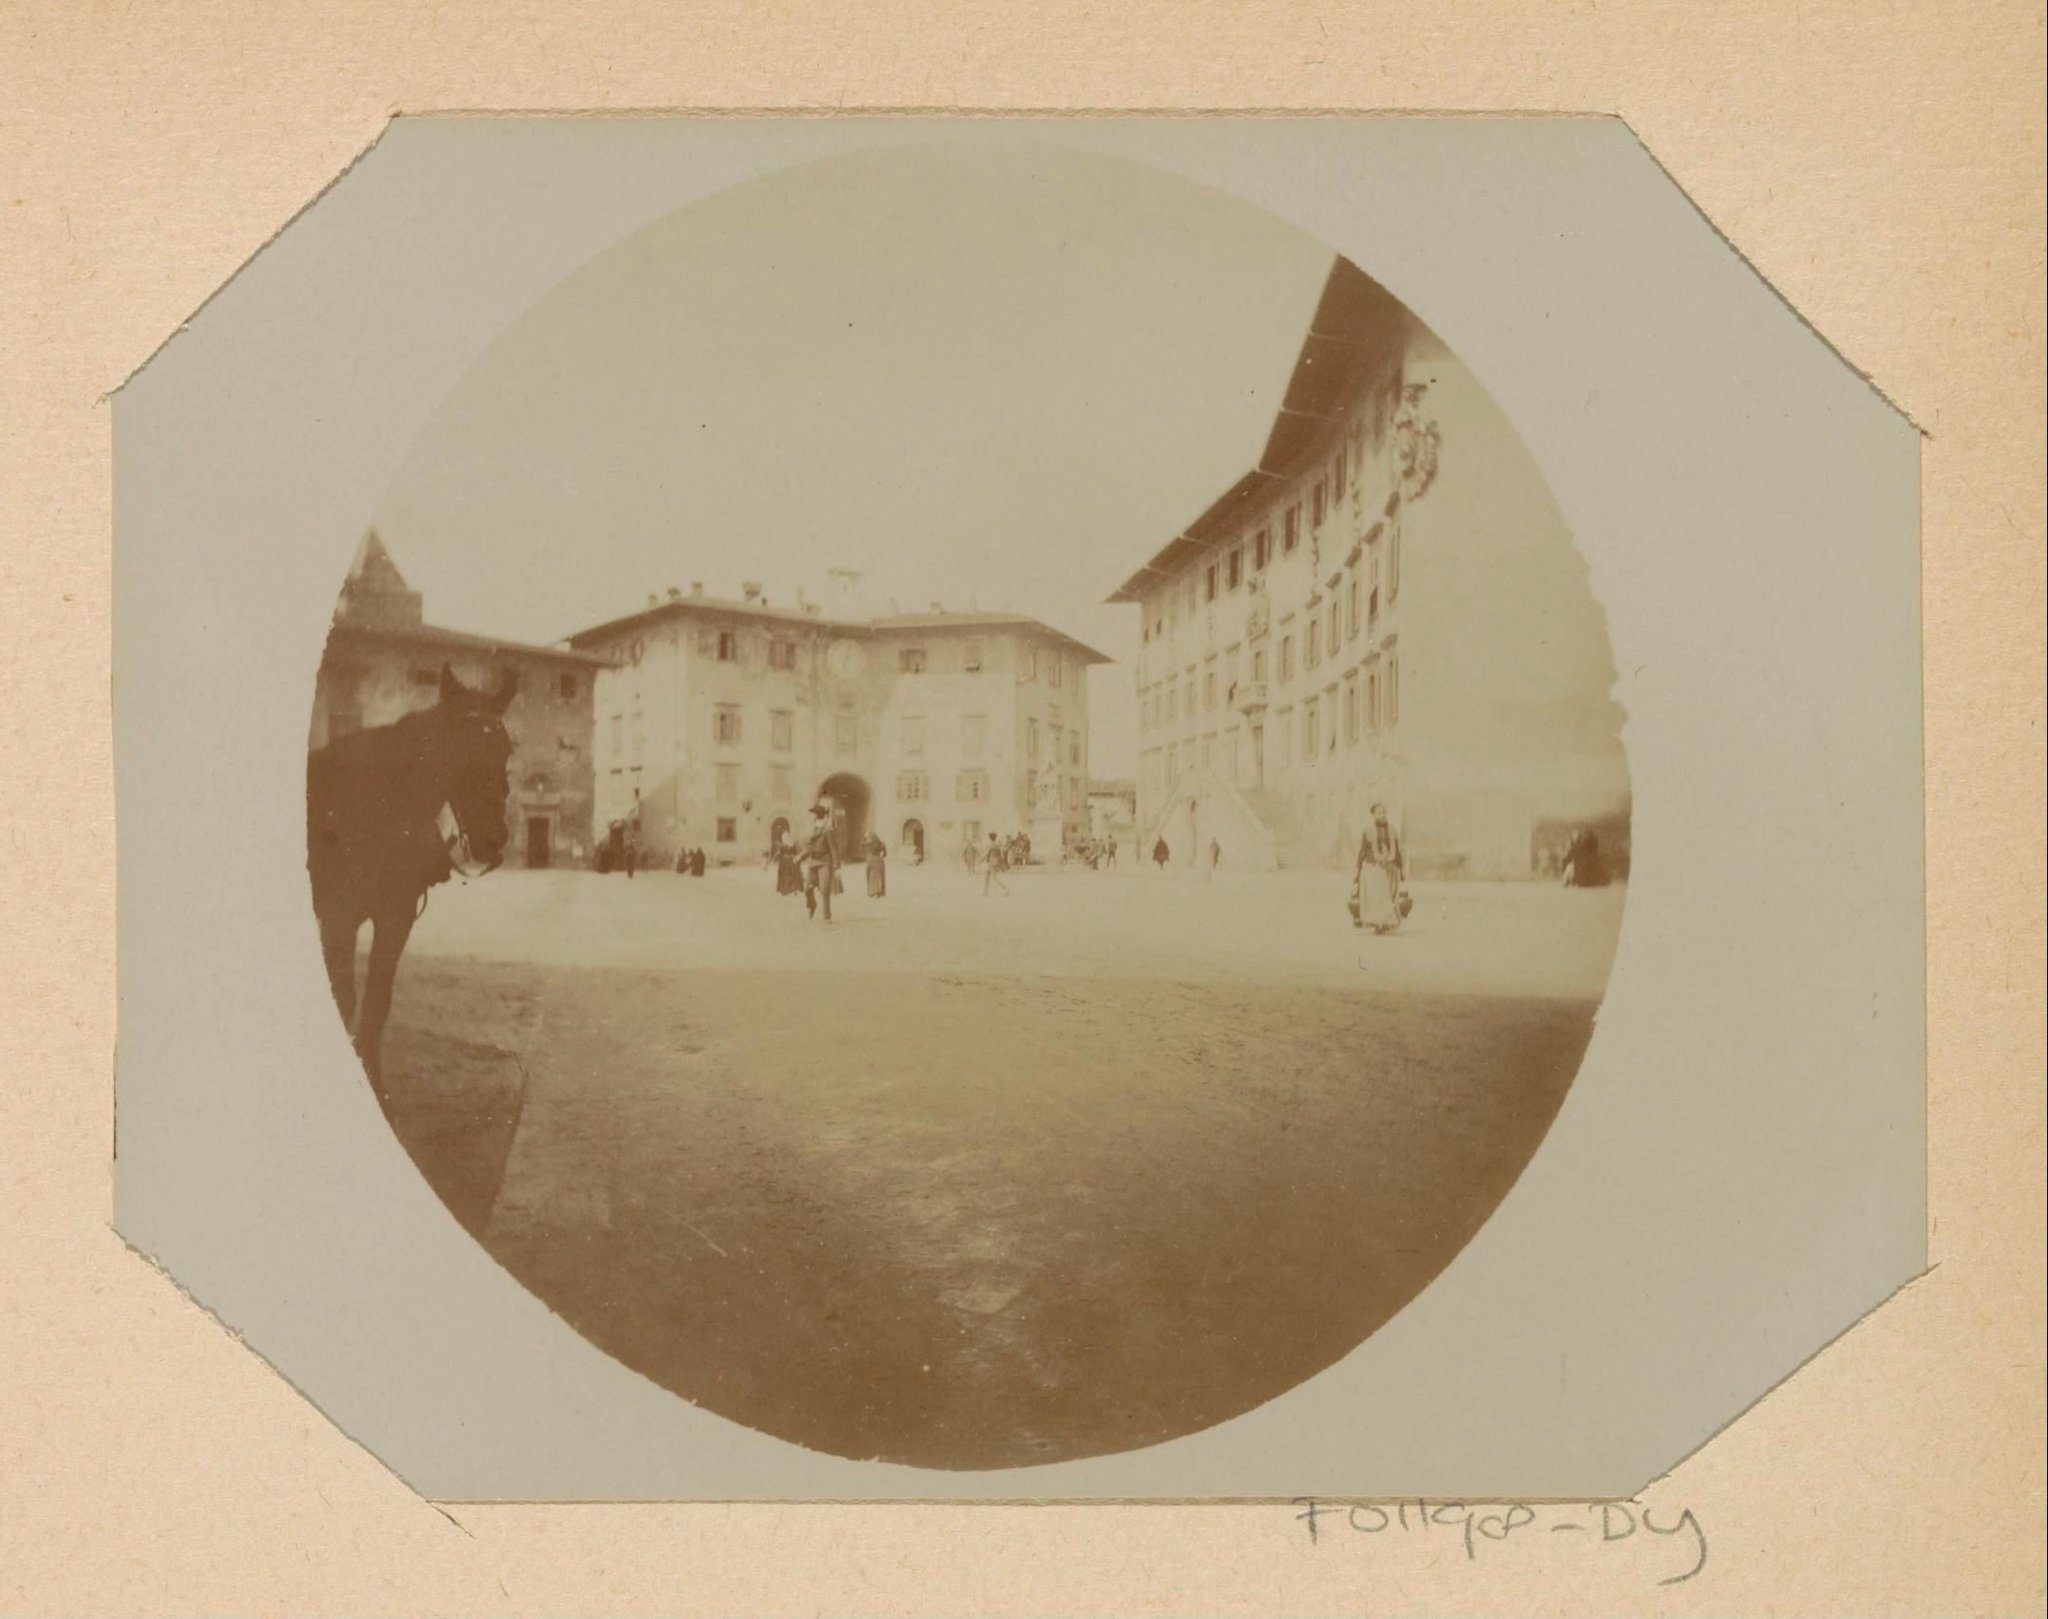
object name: album leaf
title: Pisa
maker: johanna margaretha piek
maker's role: fotograaf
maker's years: 1870-1947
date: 1889-1893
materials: paper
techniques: gelatin silver print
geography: pisa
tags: square, place, circus, etc., knights' square